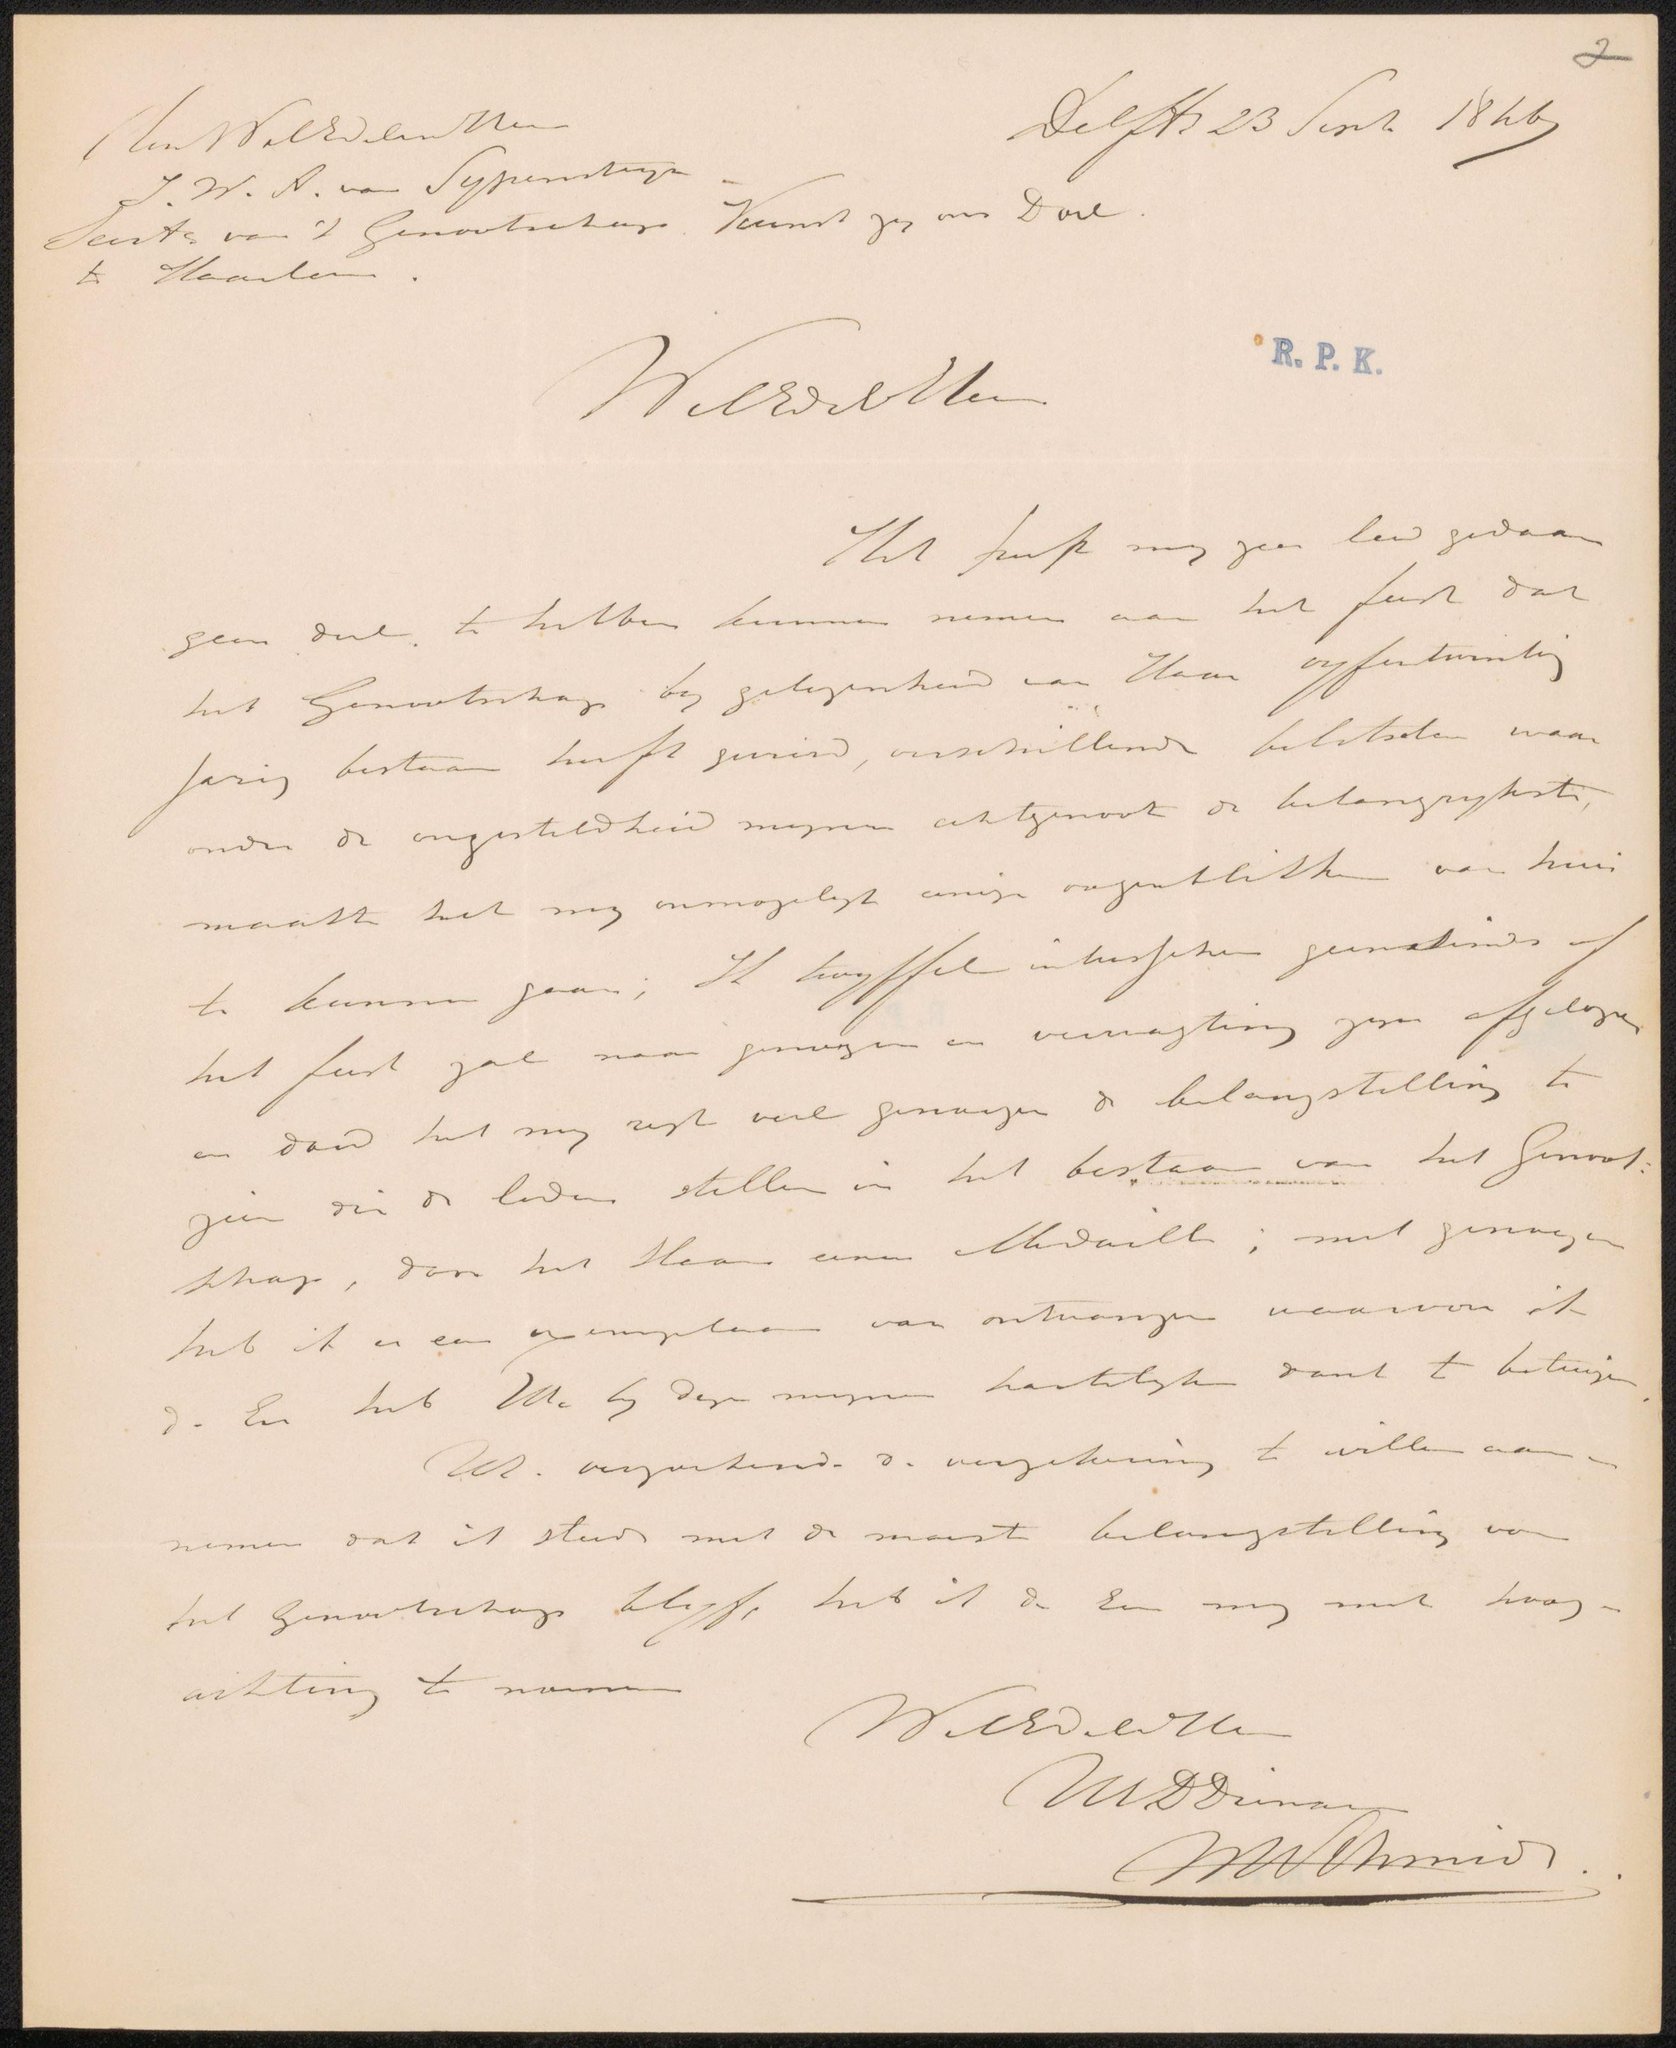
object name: letter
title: Brief aan J.W.A. van Sijpesteijn, secretaris van Maatschappij der Tekenkunst, Kunst zy ons doel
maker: willem hendrik schmidt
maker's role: draughtsman, painter, print maker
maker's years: 1809-1849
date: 1846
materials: ink, paper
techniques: pen, writing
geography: delft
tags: j.w.a. van sijpesteijn, maatschappij der tekenkunst, kunst zy ons doel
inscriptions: collector's mark: Lugt 2233